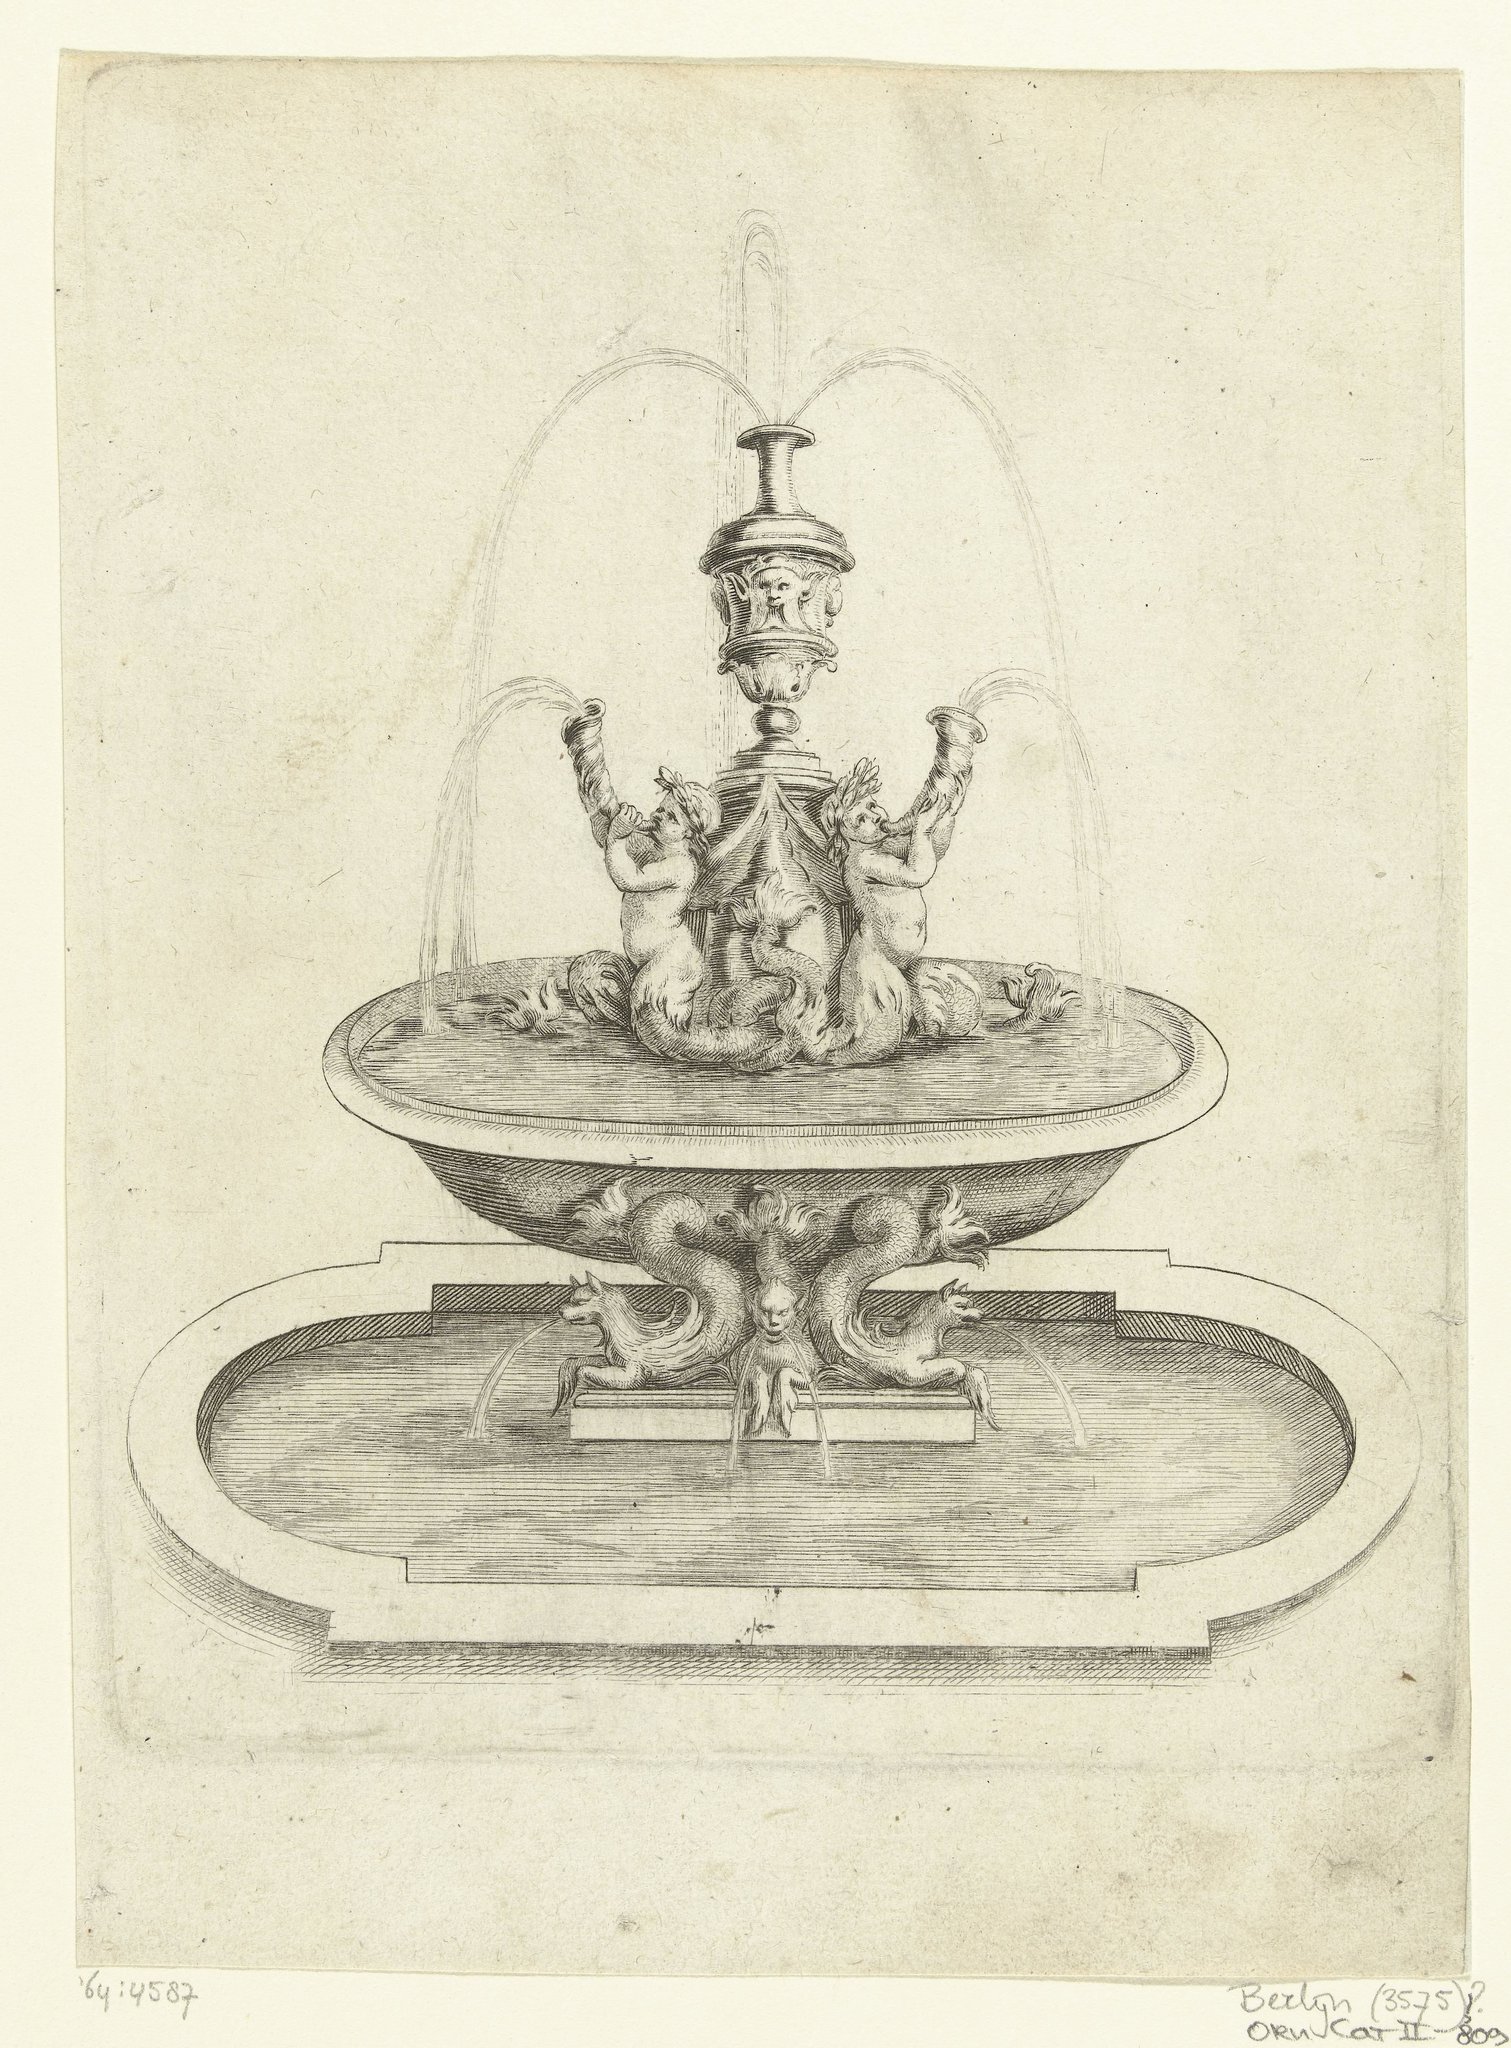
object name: ornament print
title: Fontaines Et Iets D'Eau (...)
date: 1680-1707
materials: paper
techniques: engraving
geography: paris